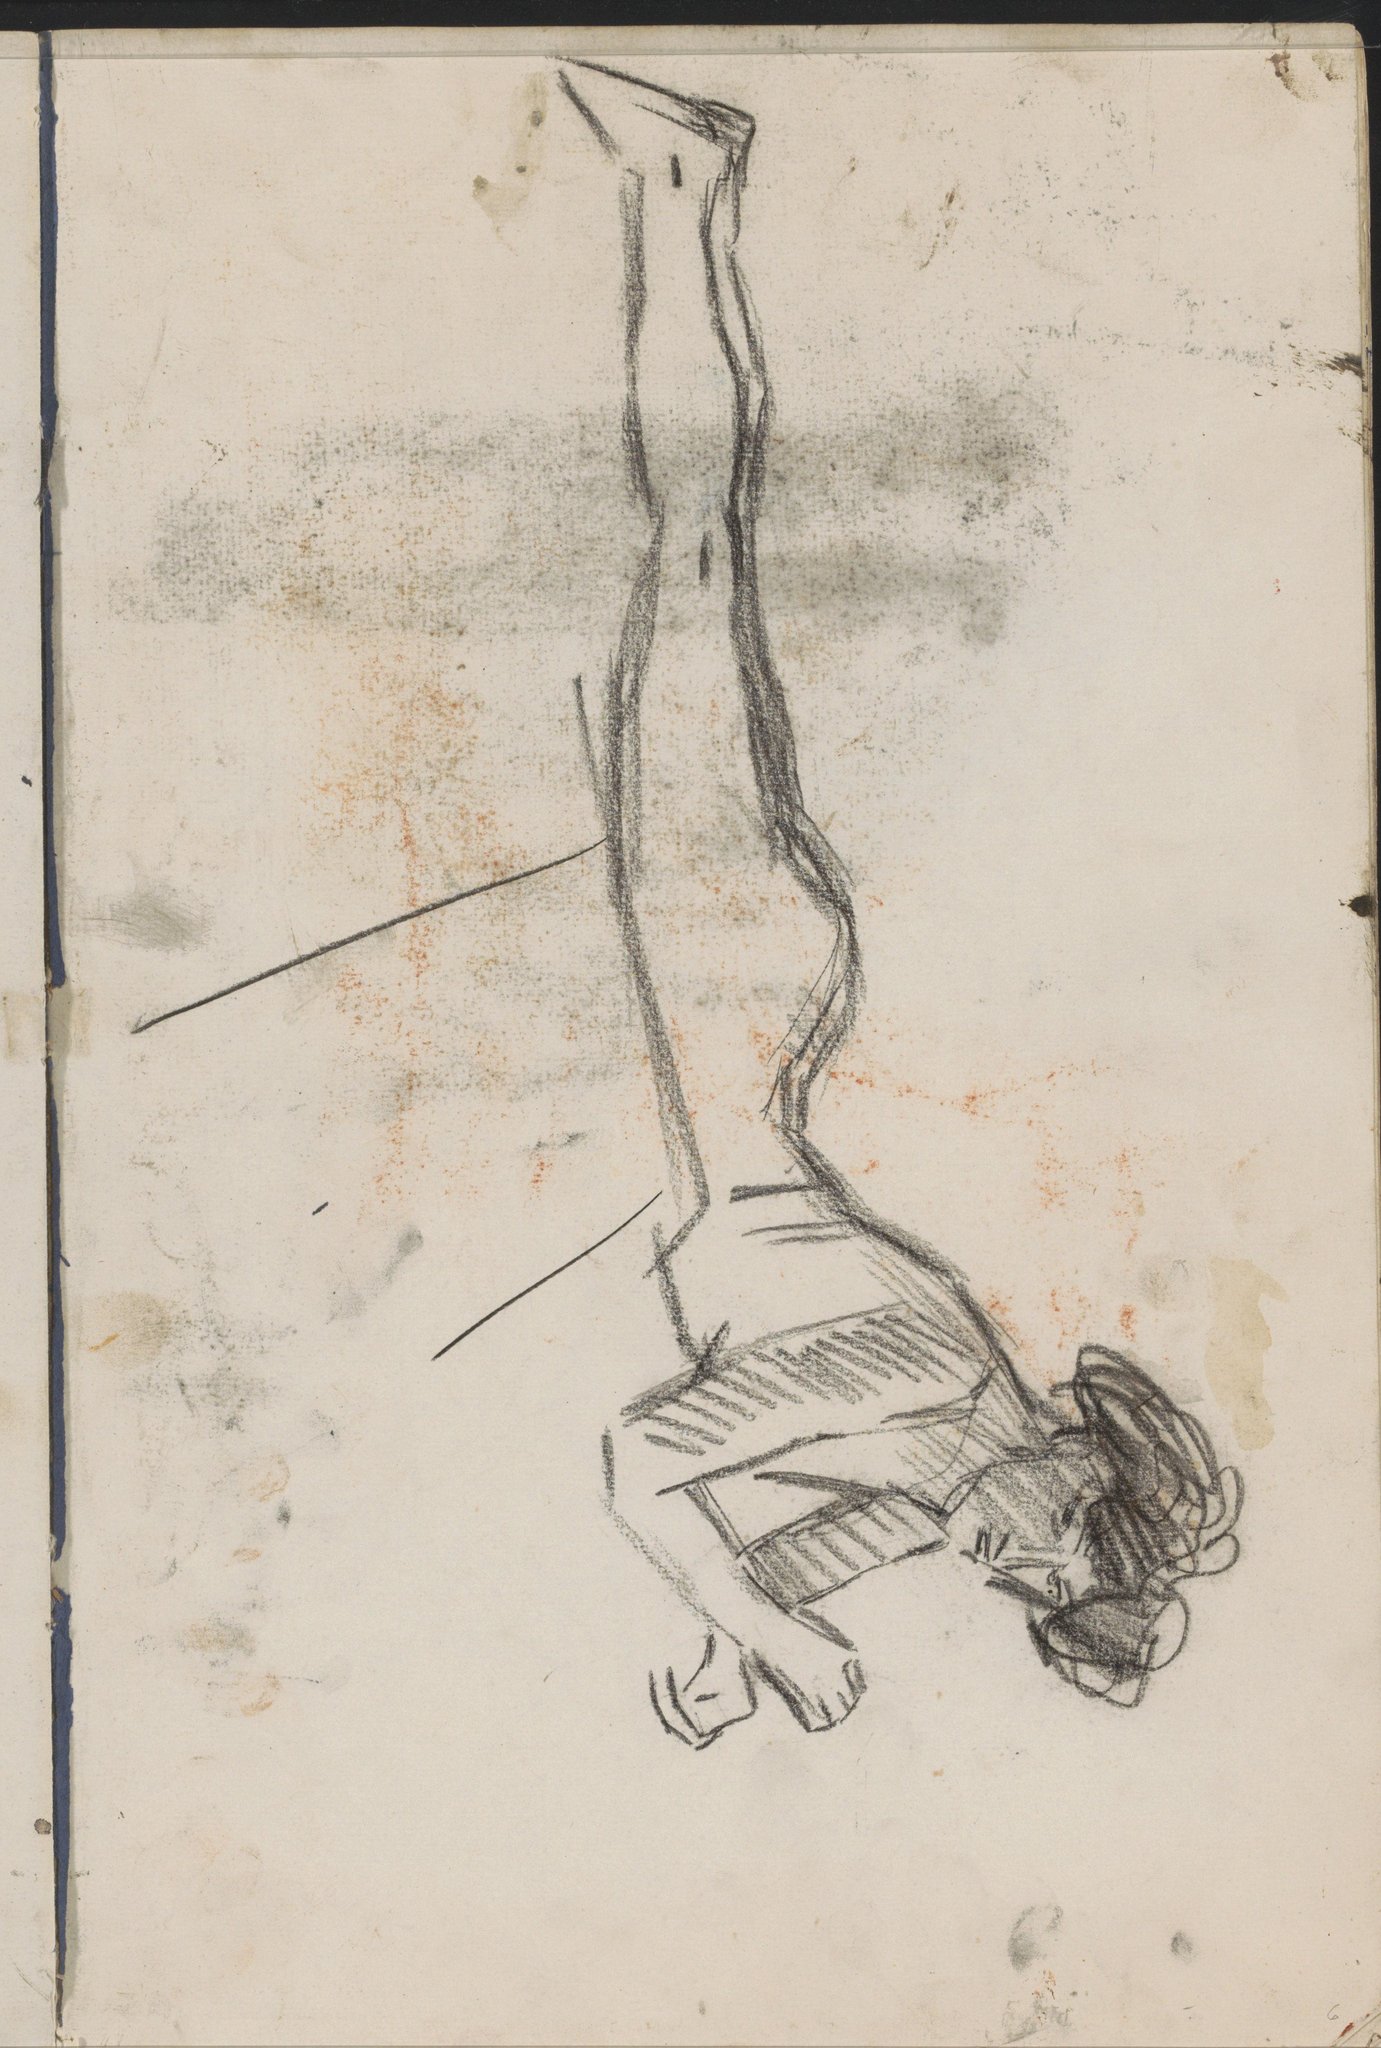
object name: sketchbook leaf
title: Vrouwelijk naakt, op haar buik liggend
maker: isaac israels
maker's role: draughtsman, painter, print maker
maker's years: 1865-1934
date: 1875-1934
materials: chalk, paper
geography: the hague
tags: lying face downwards - aa - female human figure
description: Blad 6 recto uit schetsboek LXIX met 25 bladen.